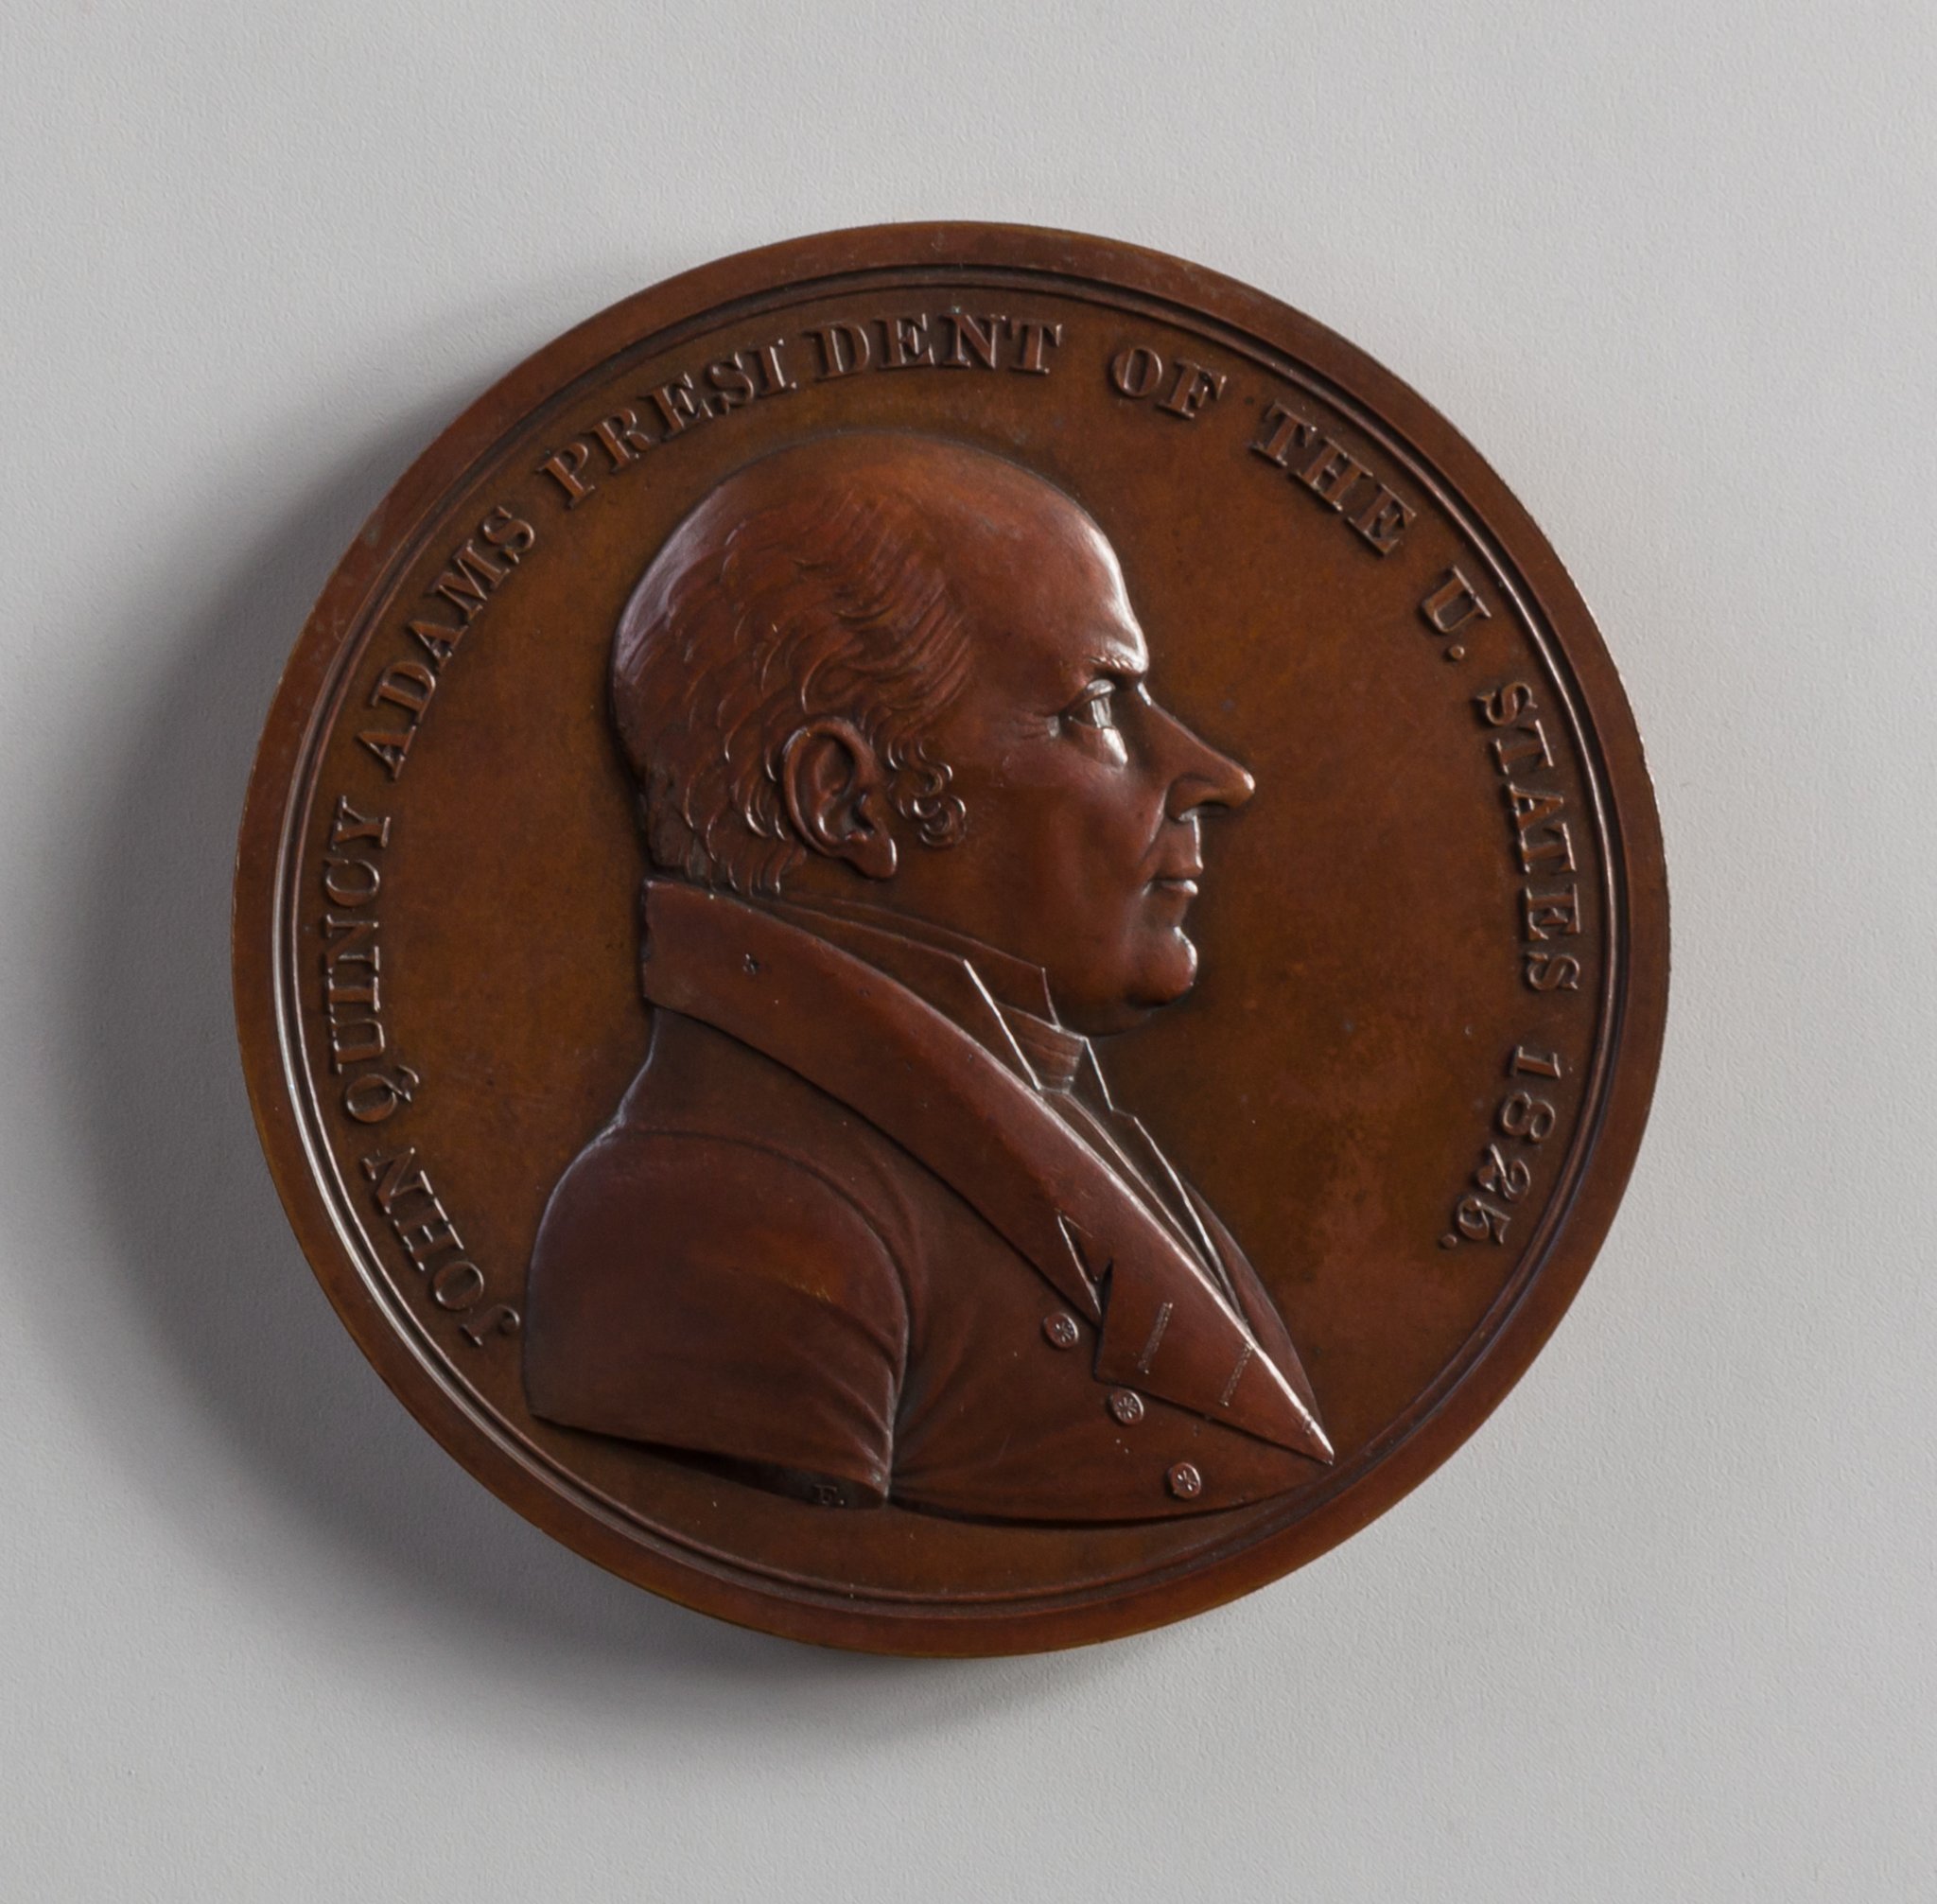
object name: medal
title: Medal of John Quincy Adams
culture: american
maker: moritz fürst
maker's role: maker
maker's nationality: hungarian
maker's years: 1782-1882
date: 1825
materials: bronze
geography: united states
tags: men,profiles